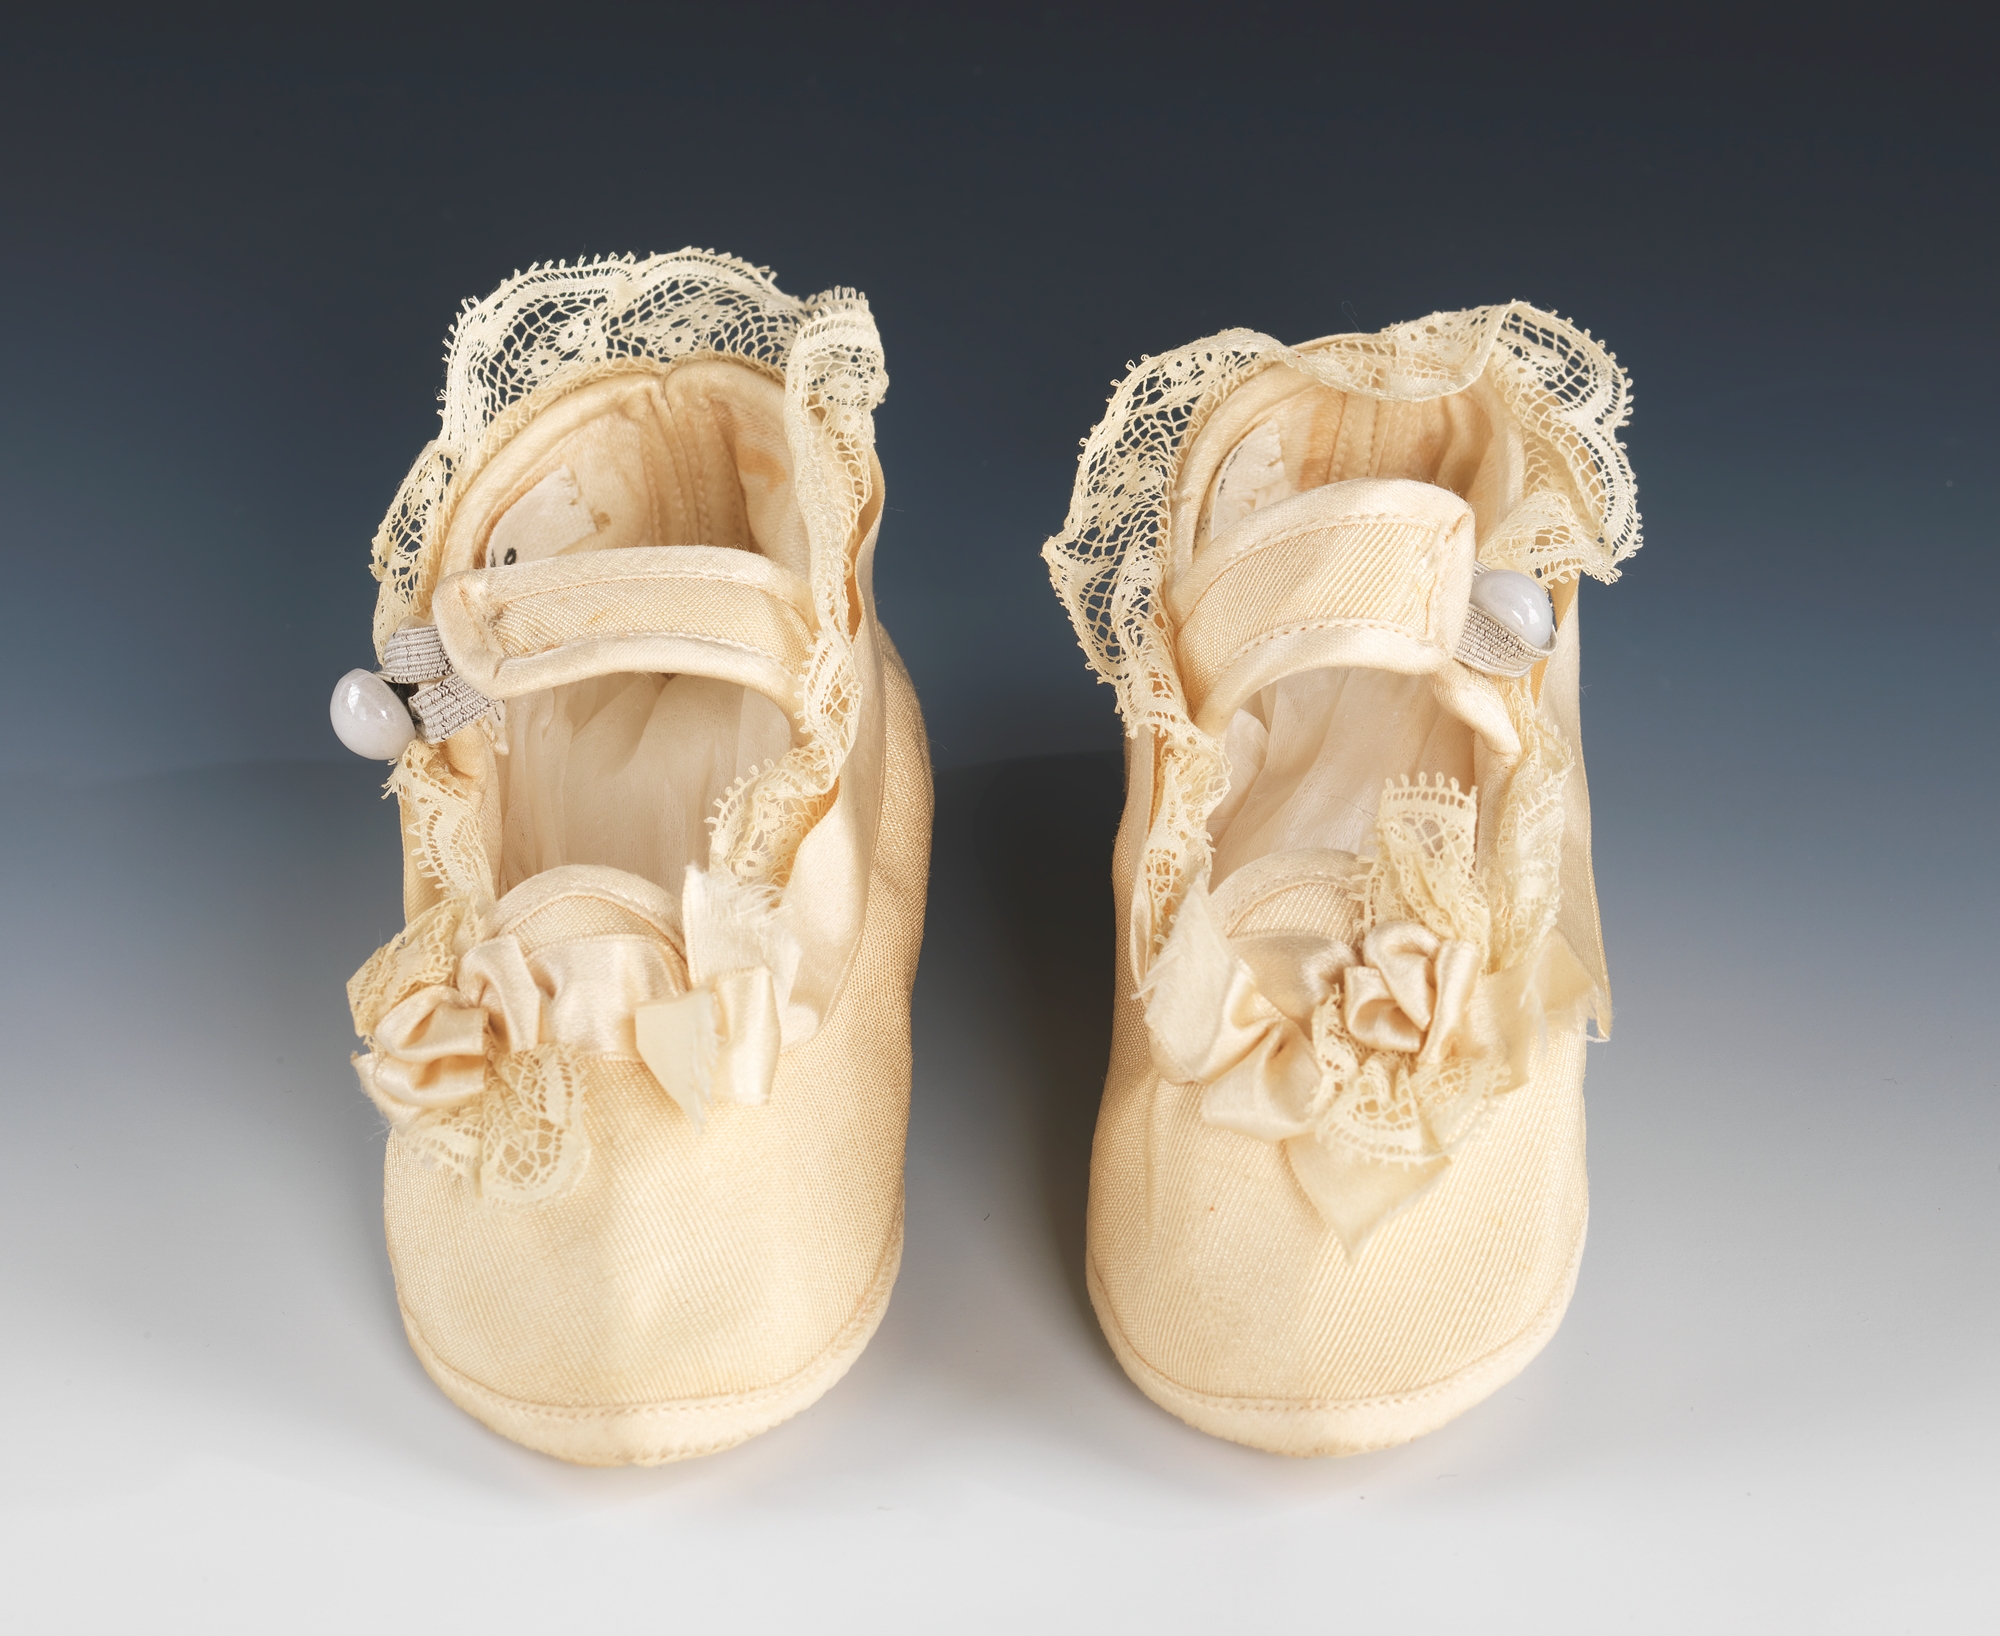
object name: shoe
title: Shoes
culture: american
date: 1869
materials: leather, linen, silk